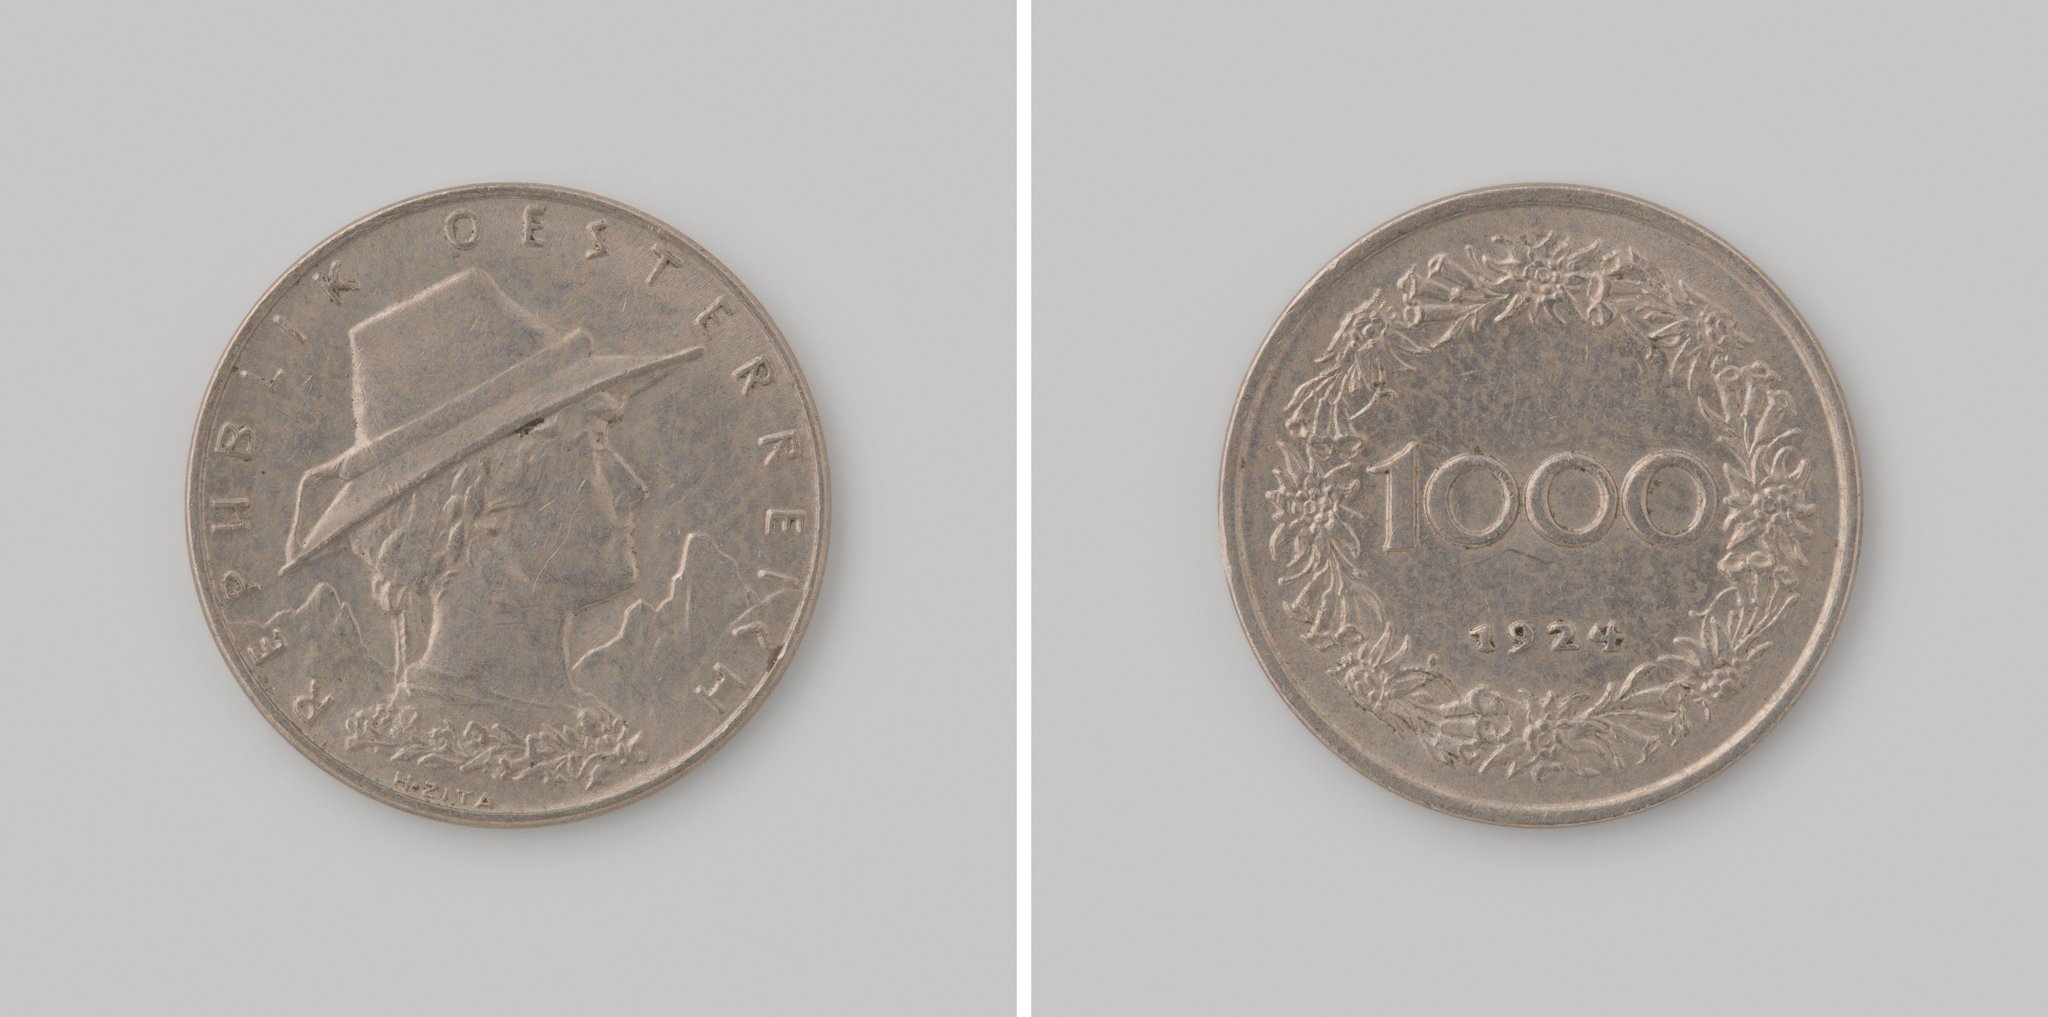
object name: coin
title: 1000 kronen uit de republiek Oostenrijk,1924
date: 1924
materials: nickel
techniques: striking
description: Nikkelen munt. Voorzijde: tussen bergtoppen borstbeeld van een vrouw met hoed naar rechts. Keerzijde: tussen twee samengevlochten takken waarde-aanduiding, waaronder jaartal. Gladde rand.